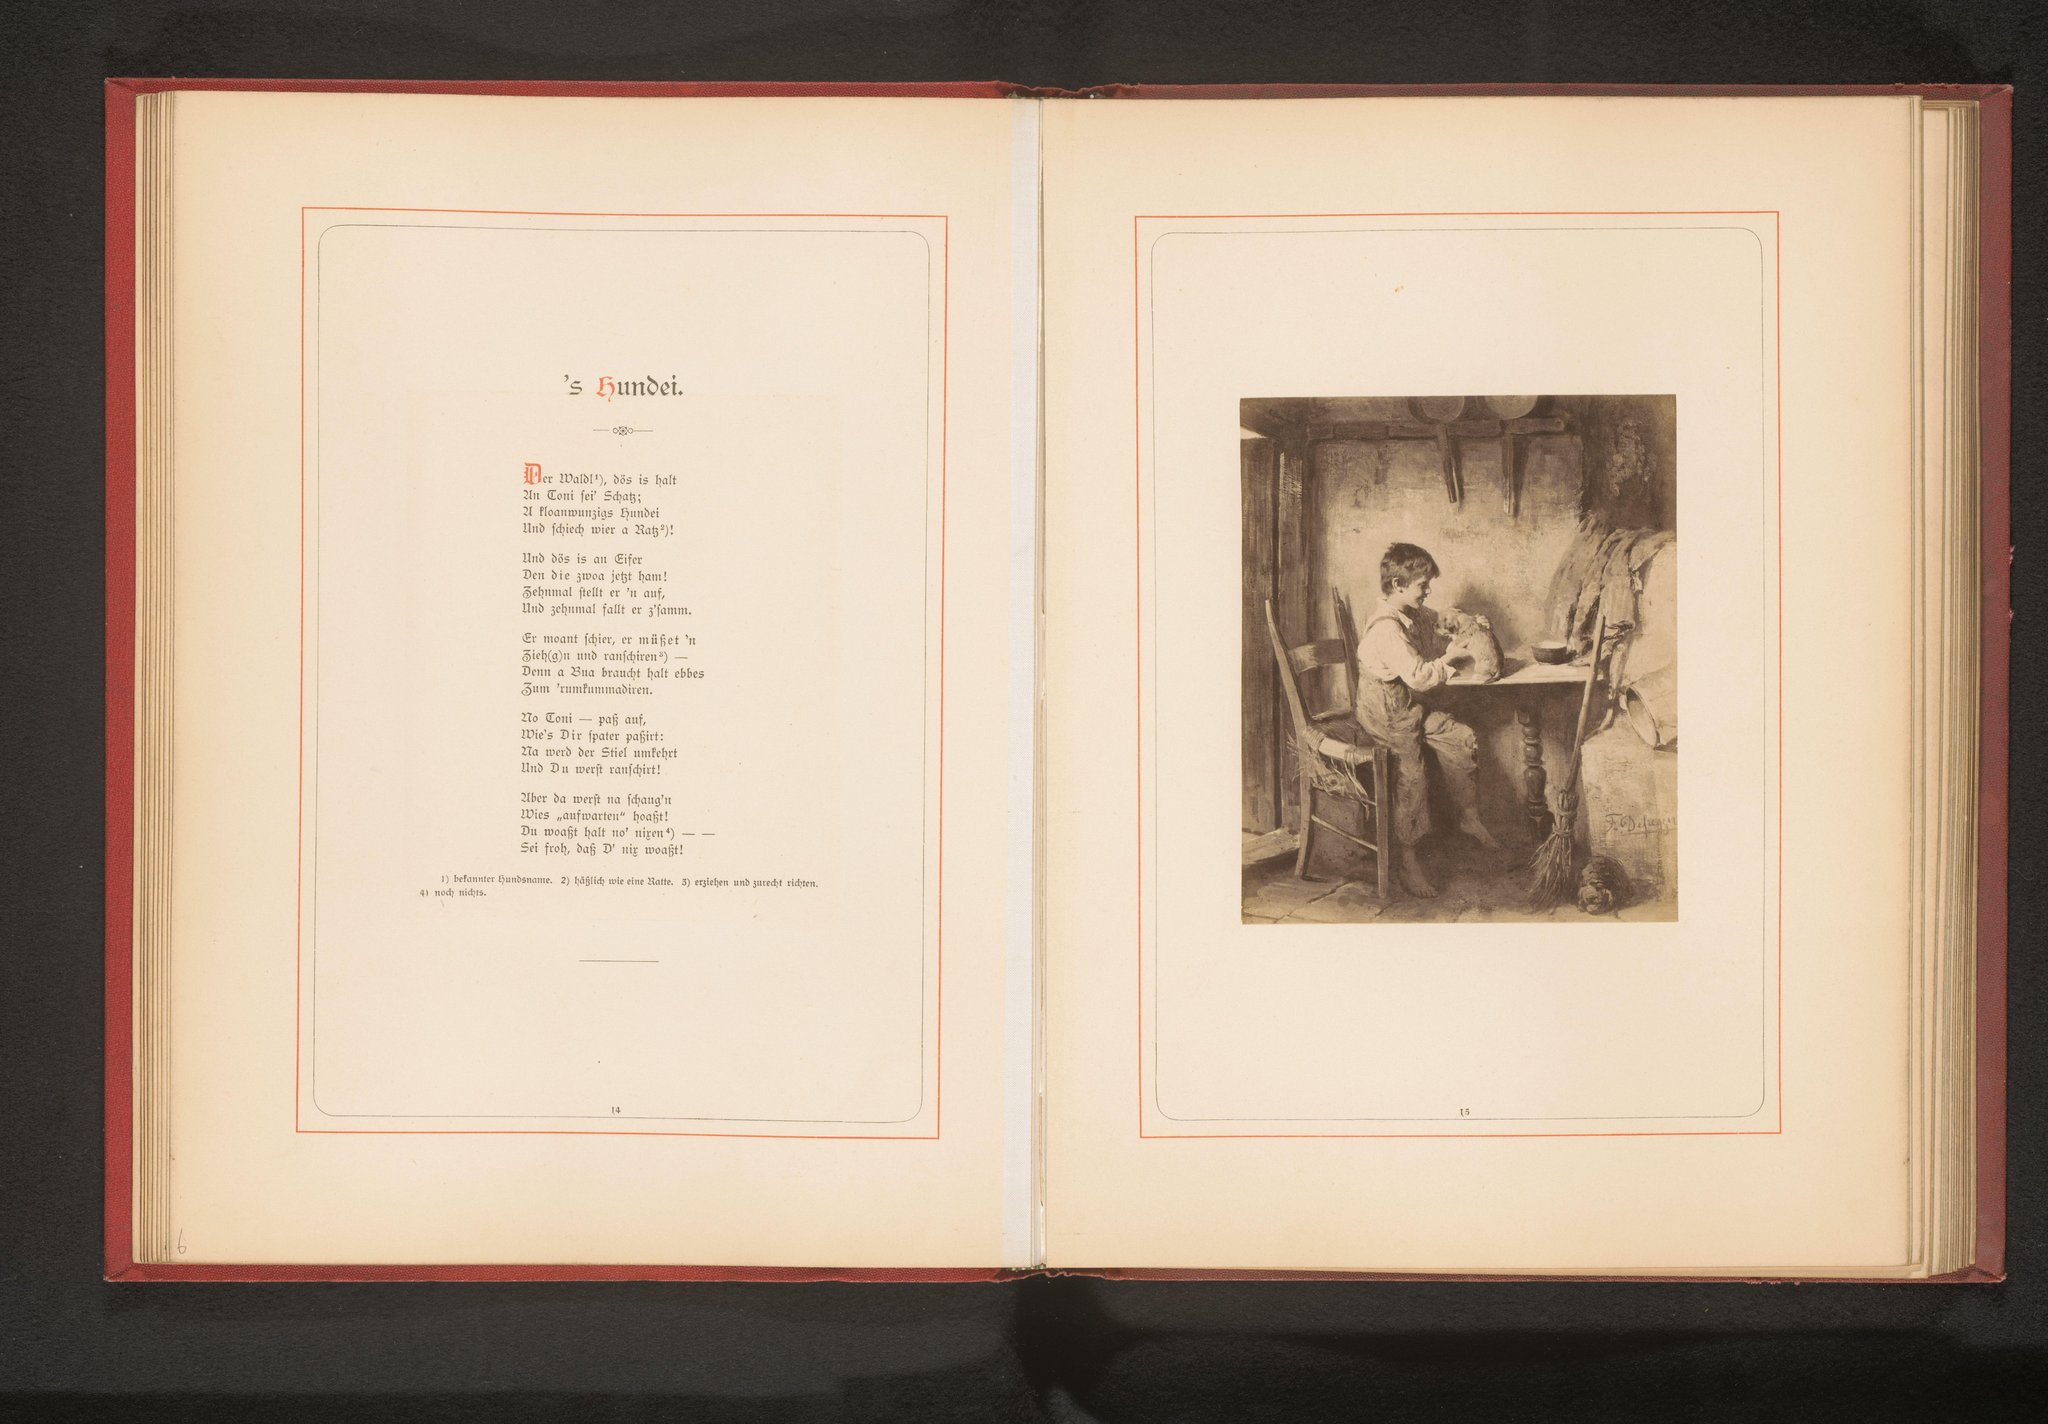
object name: photograph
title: Fotoreproductie van een schilderij, voorstellende een jongen met een puppy aan een tafel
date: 1875-1885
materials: photographic support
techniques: albumen print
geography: germany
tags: boy (child between toddler and youth), table, dog